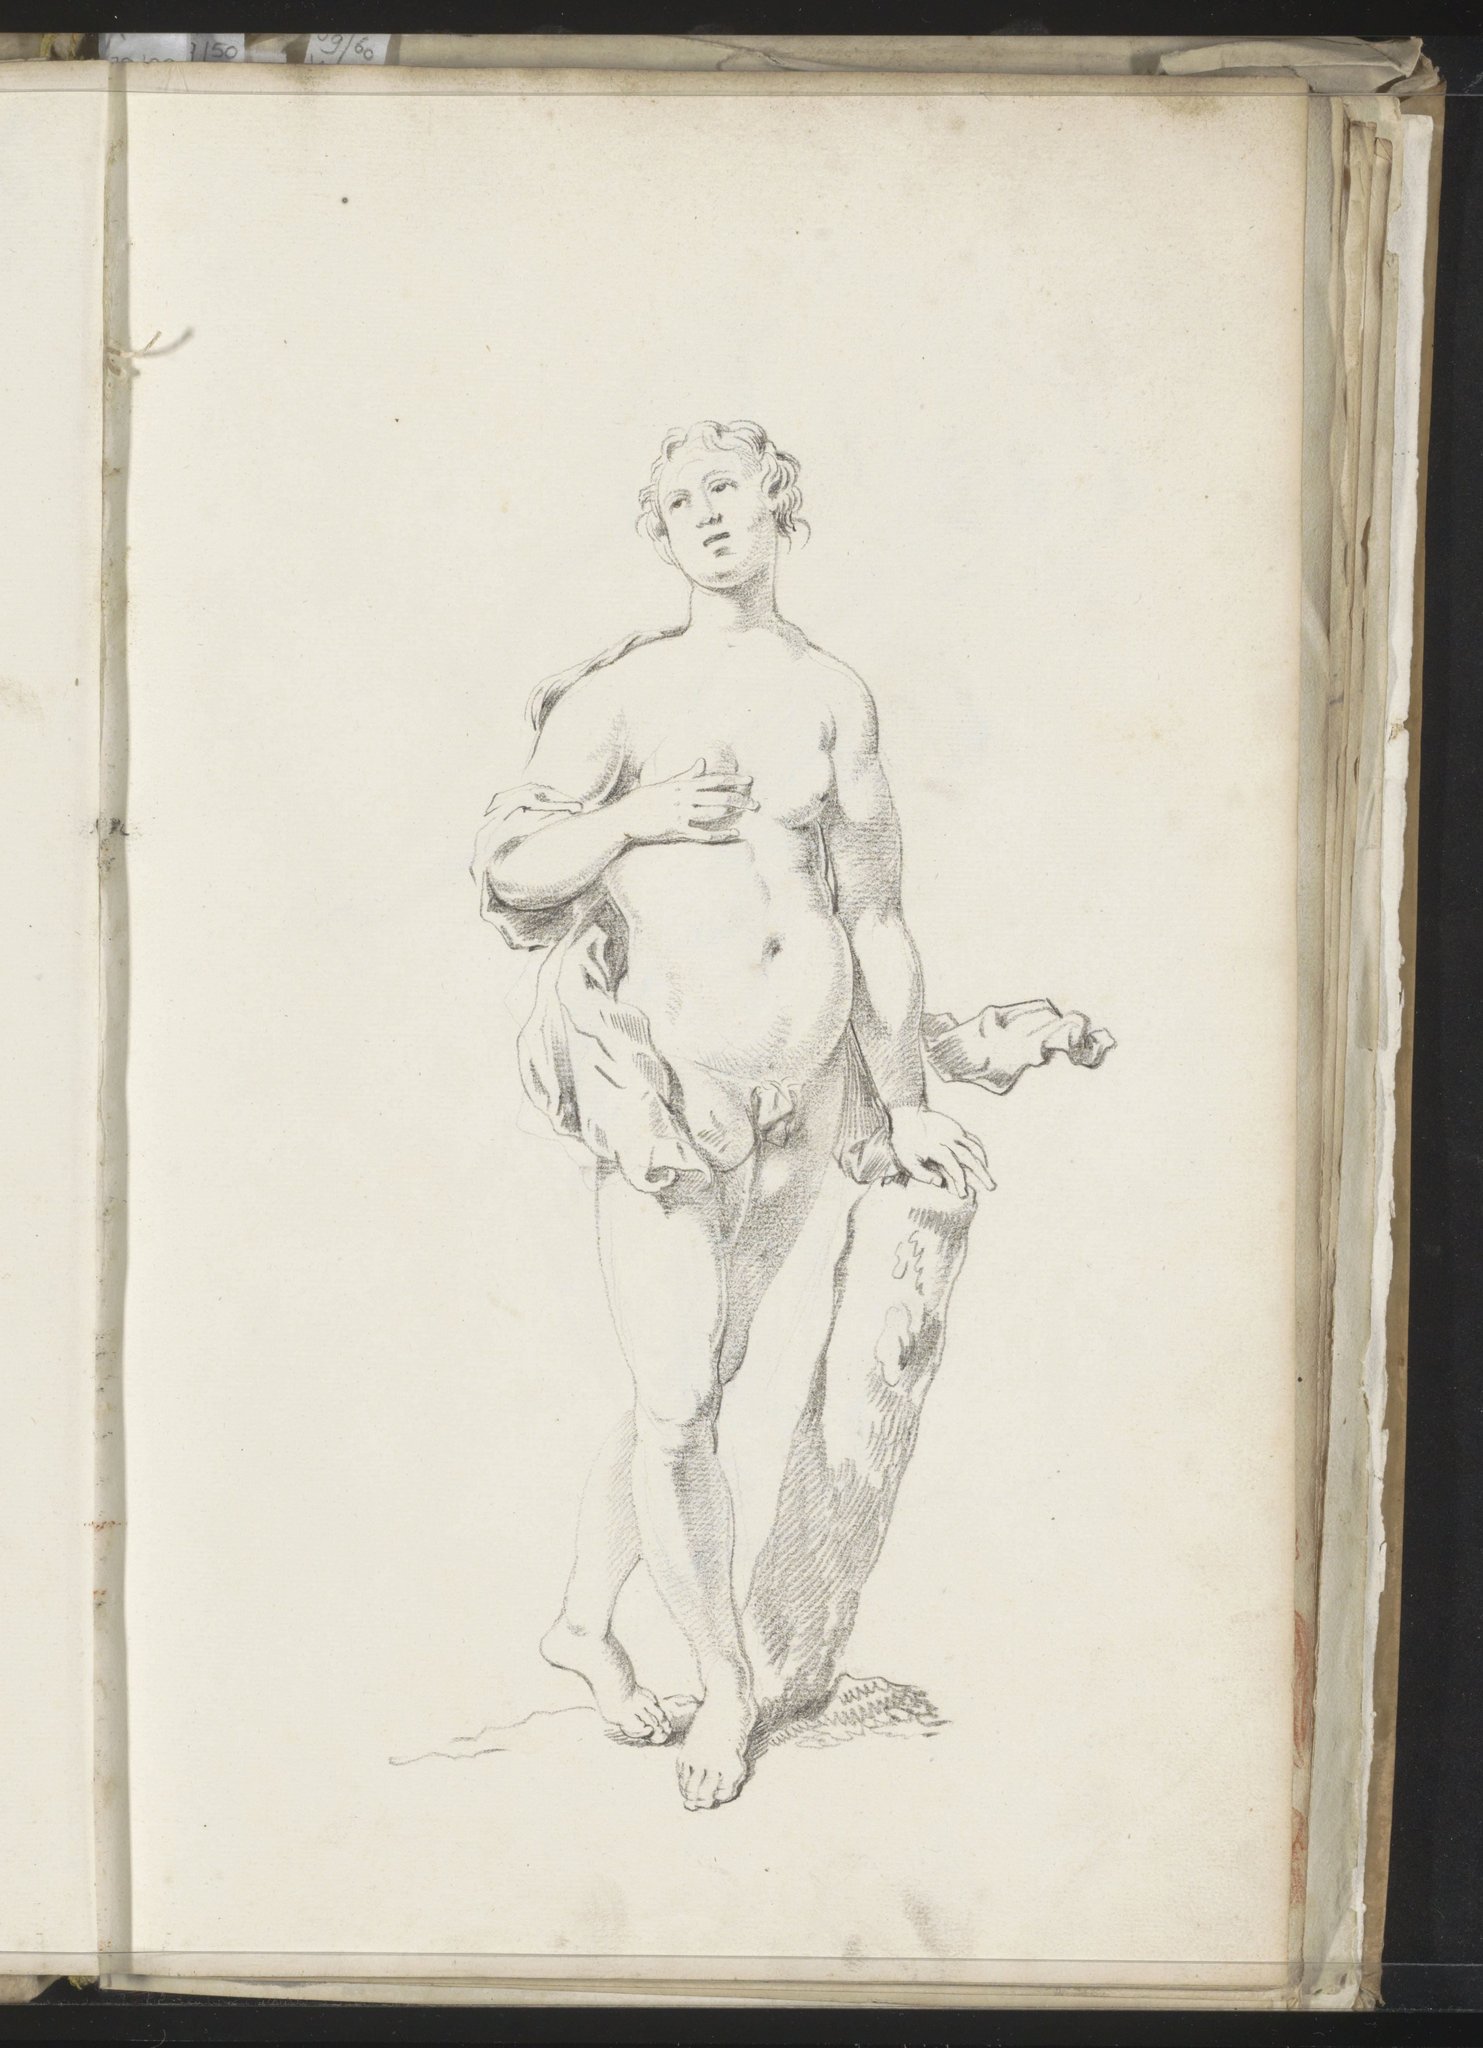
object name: sketchbook leaf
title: Staande naakte vrouw bij een boomstam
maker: jacob toorenvliet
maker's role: draughtsman, painter, print maker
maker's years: 1640-1719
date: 1701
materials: chalk, paper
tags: trees (+ stem, trunk), the (nude) human figure; 'corpo humano' (ripa) - aa - female human figure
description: Blad 18 recto uit een schetsboek met 63 bladen.